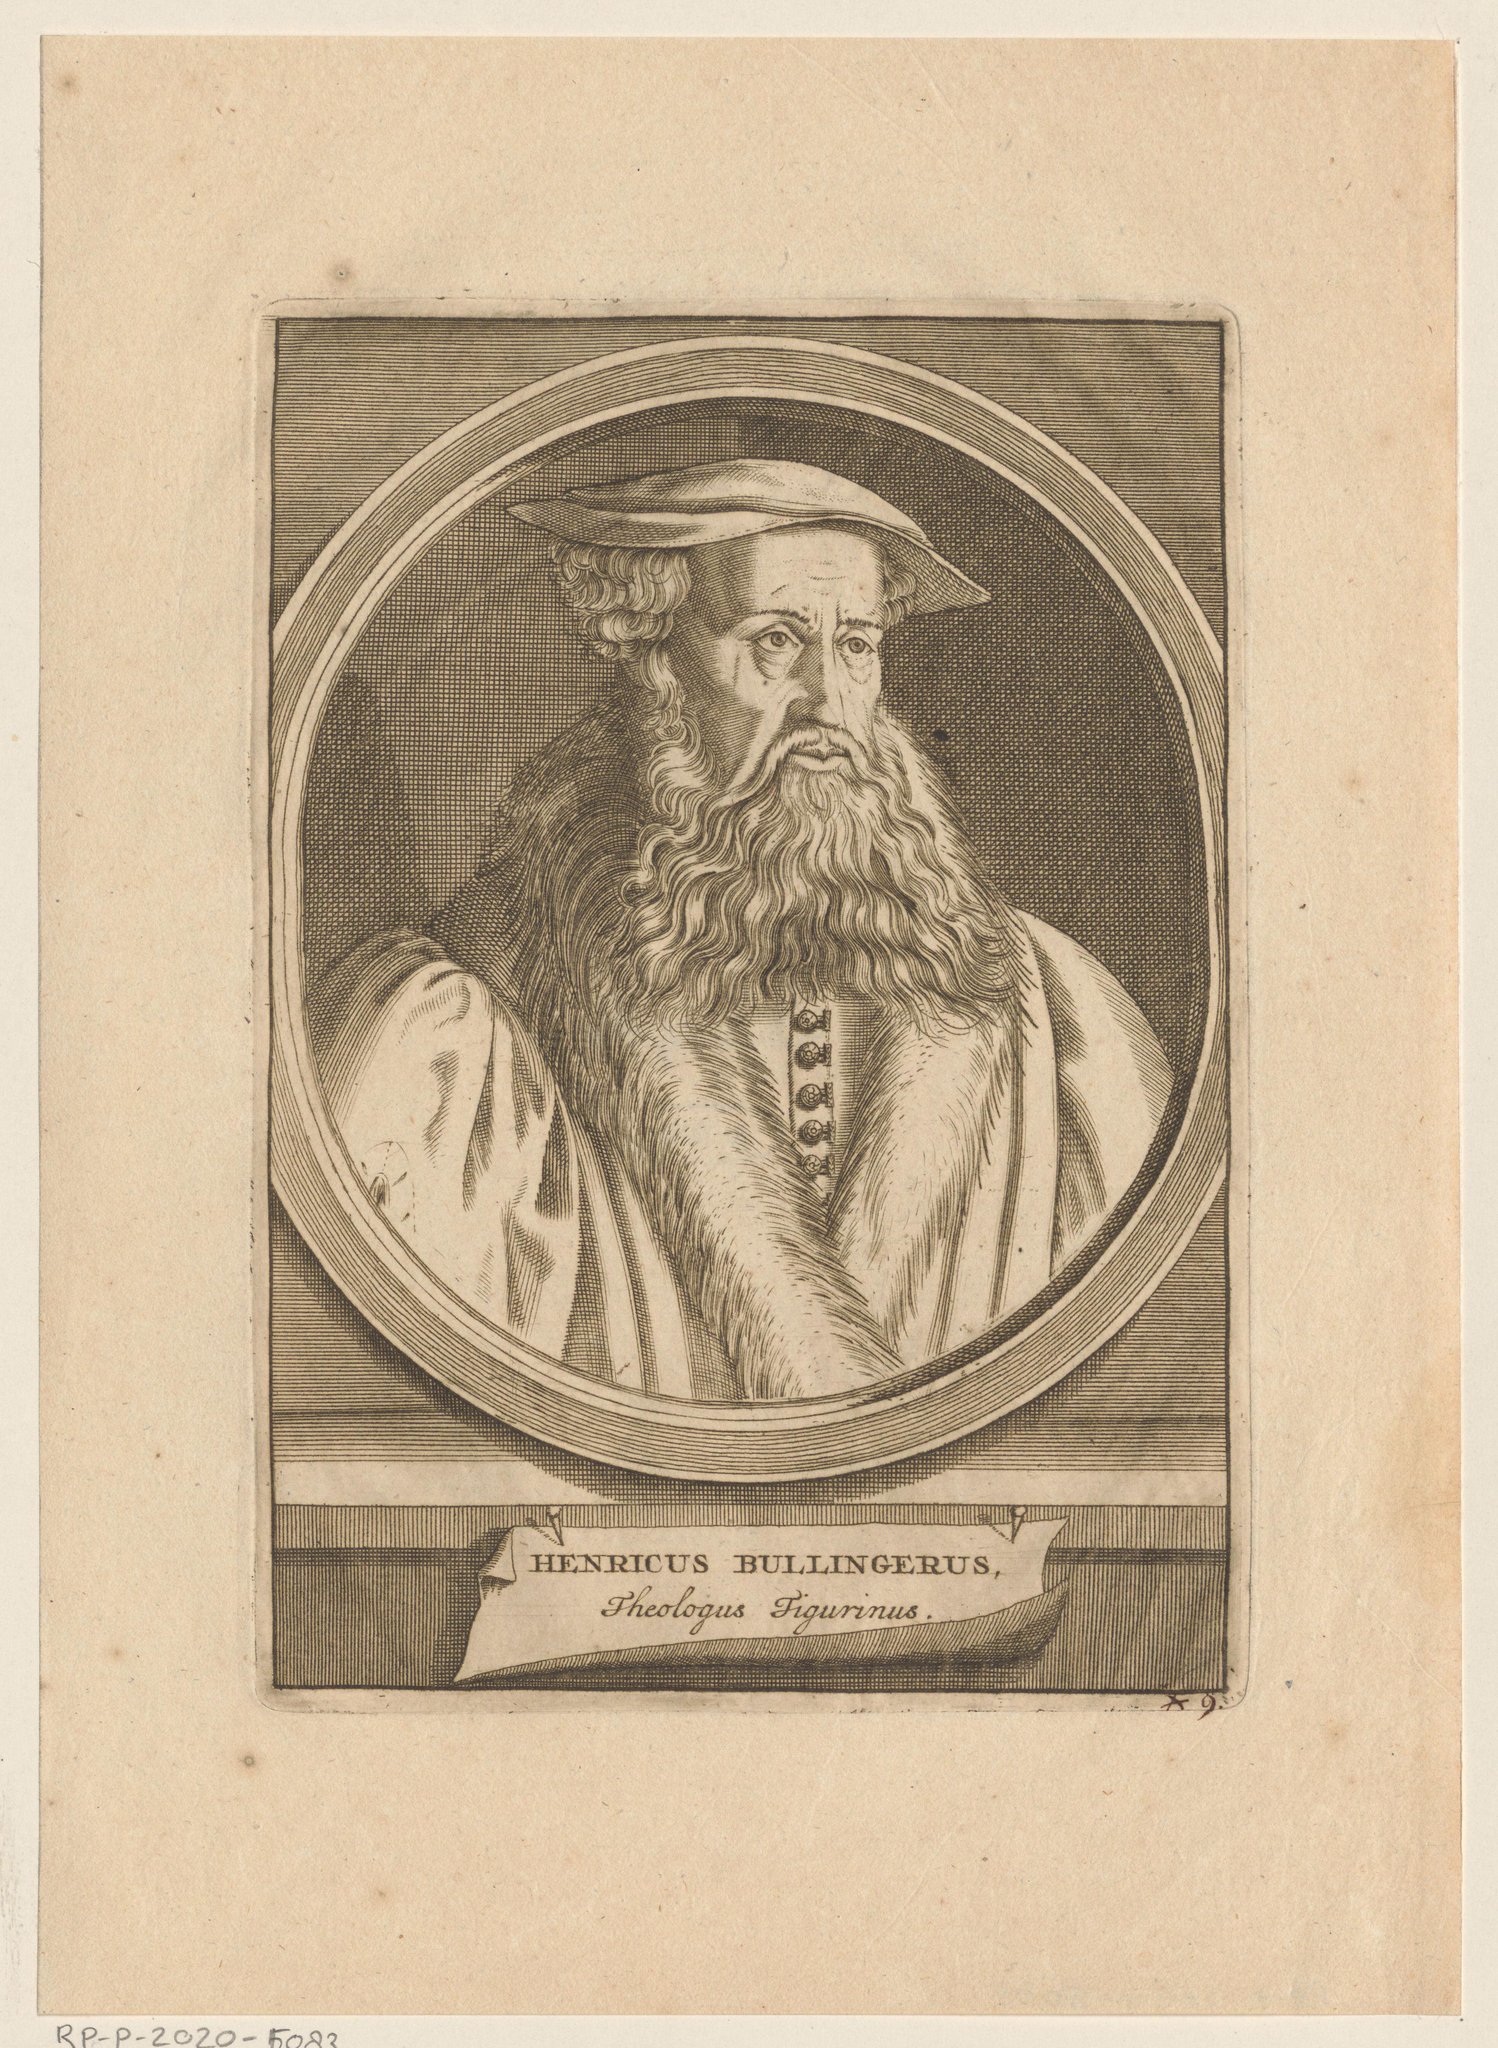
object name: print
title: Portret van Johann Heinrich Bullinger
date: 1599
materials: paper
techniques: engraving, etching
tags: theologian, historical persons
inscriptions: collector's mark: Lugt 2228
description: Eerste staat van deze prent verschenen in: Icones virorum nostra patrumq. memoria illustrium (...). Den Haag: Hendrick Hondius (I), 1599. Prent ook gebruikt in latere publicaties.